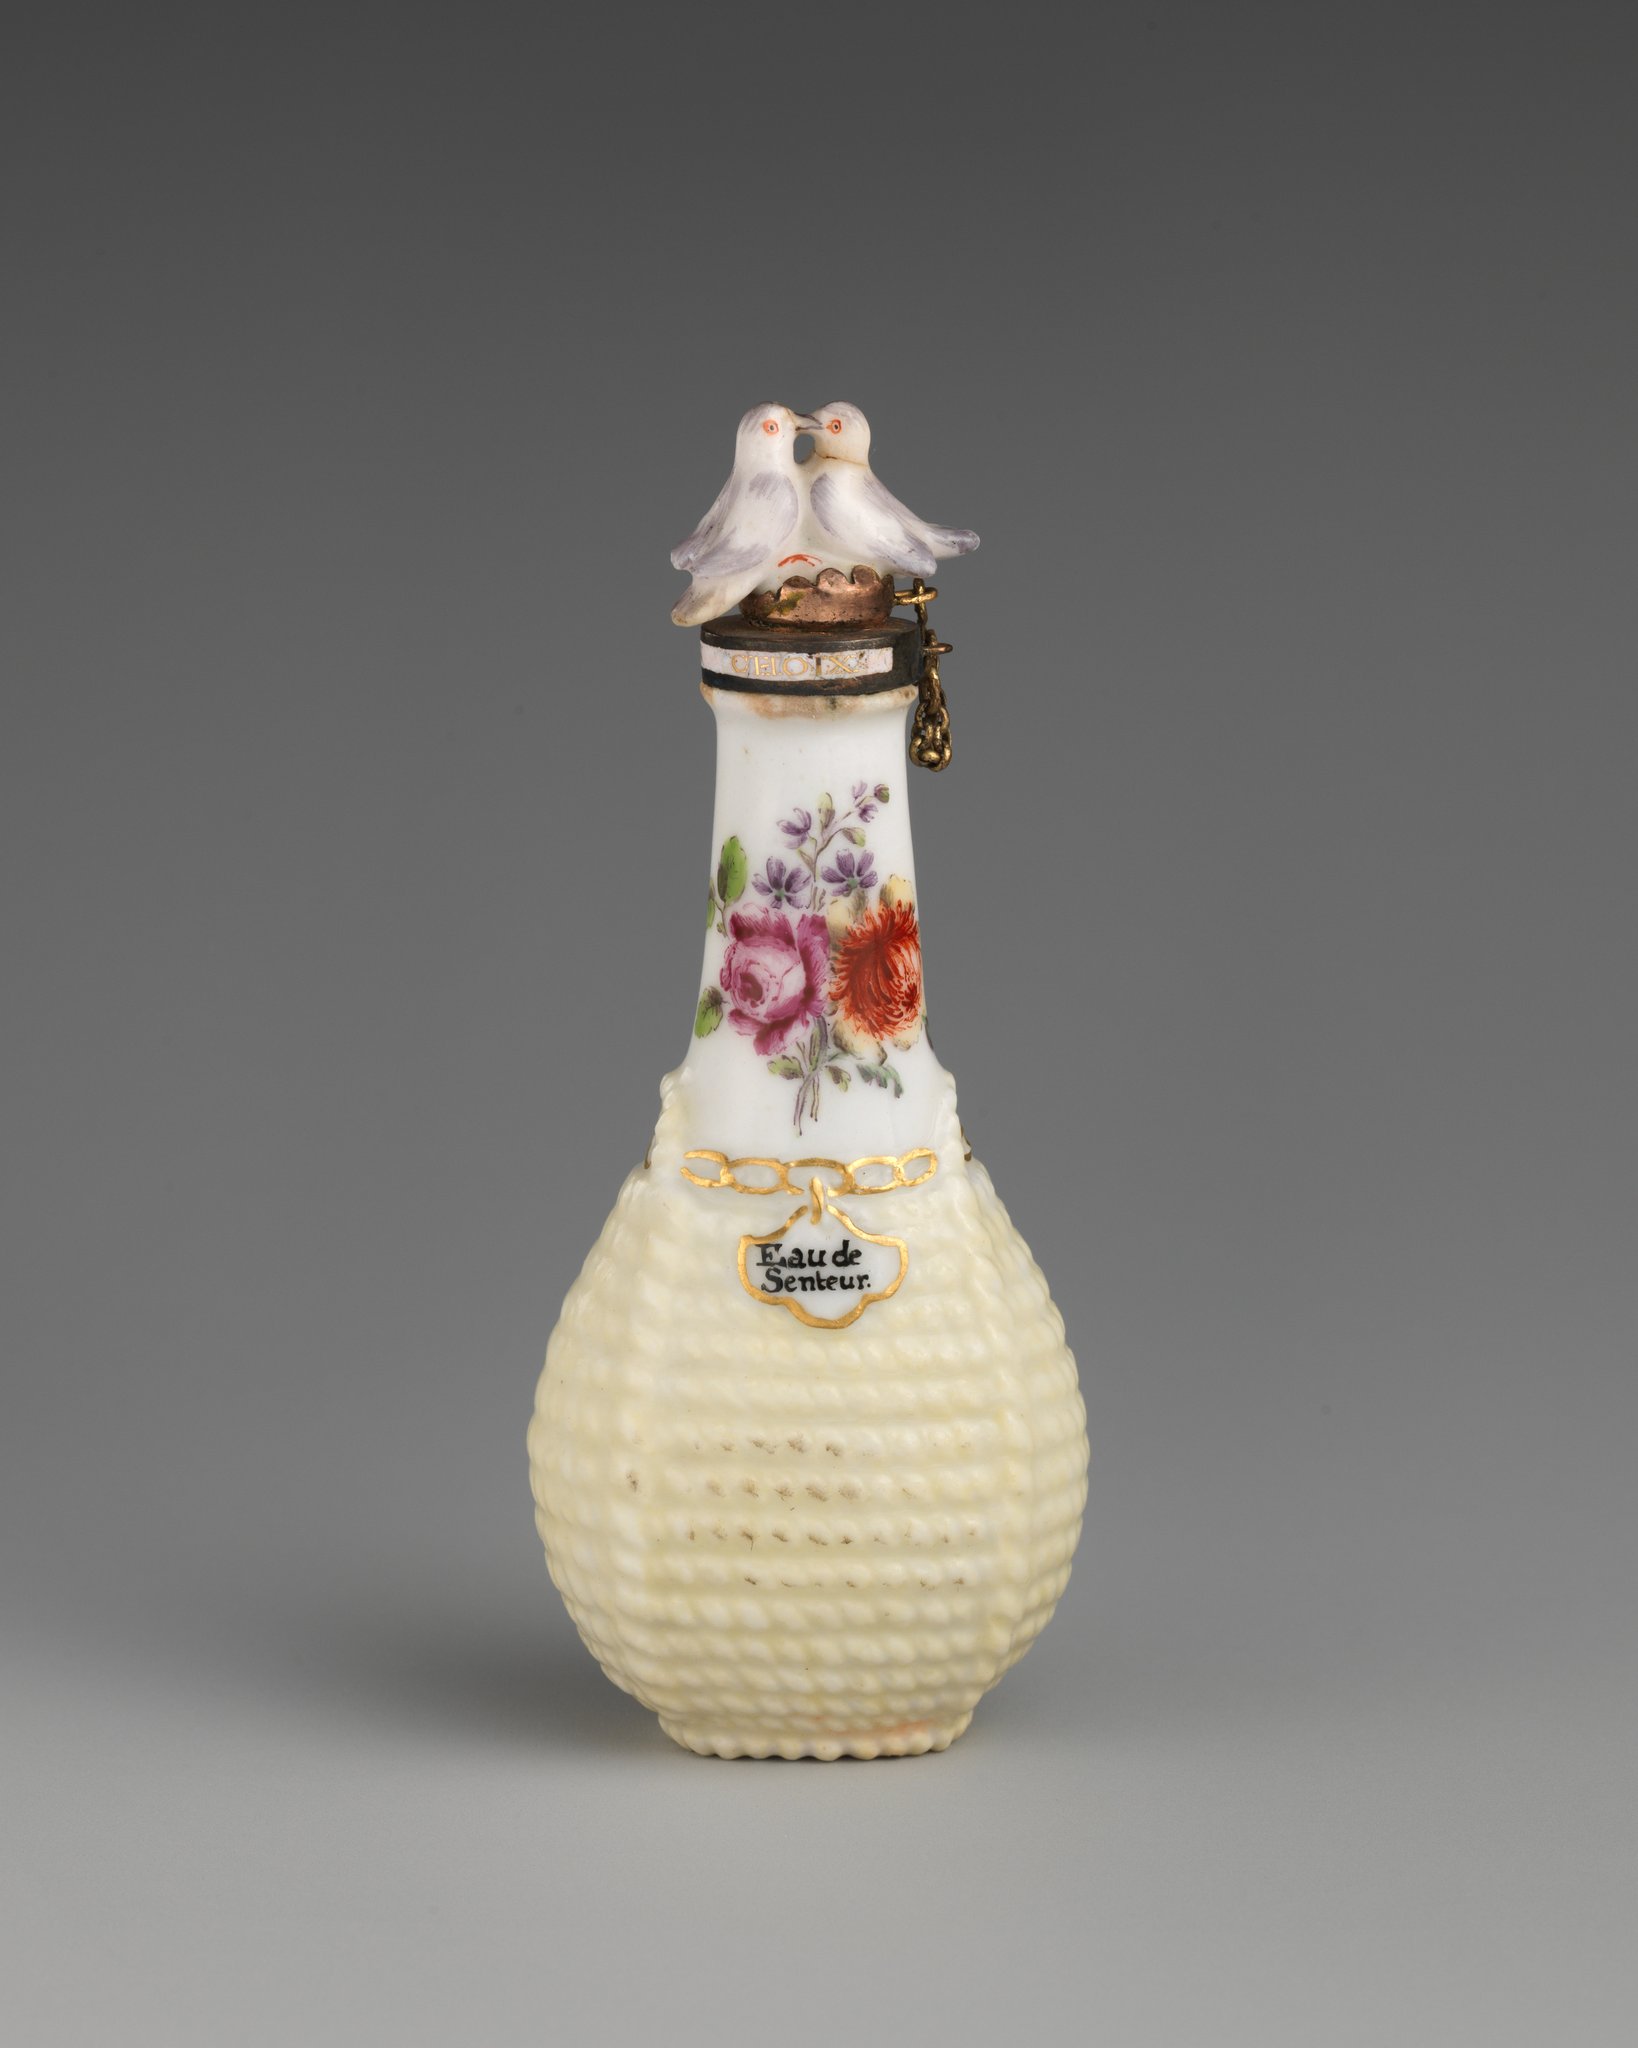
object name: toy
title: Flagon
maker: chelsea porcelain manufactory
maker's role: factory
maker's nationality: british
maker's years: 1744-1784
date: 1755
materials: soft paste porcelain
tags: birds,flowers